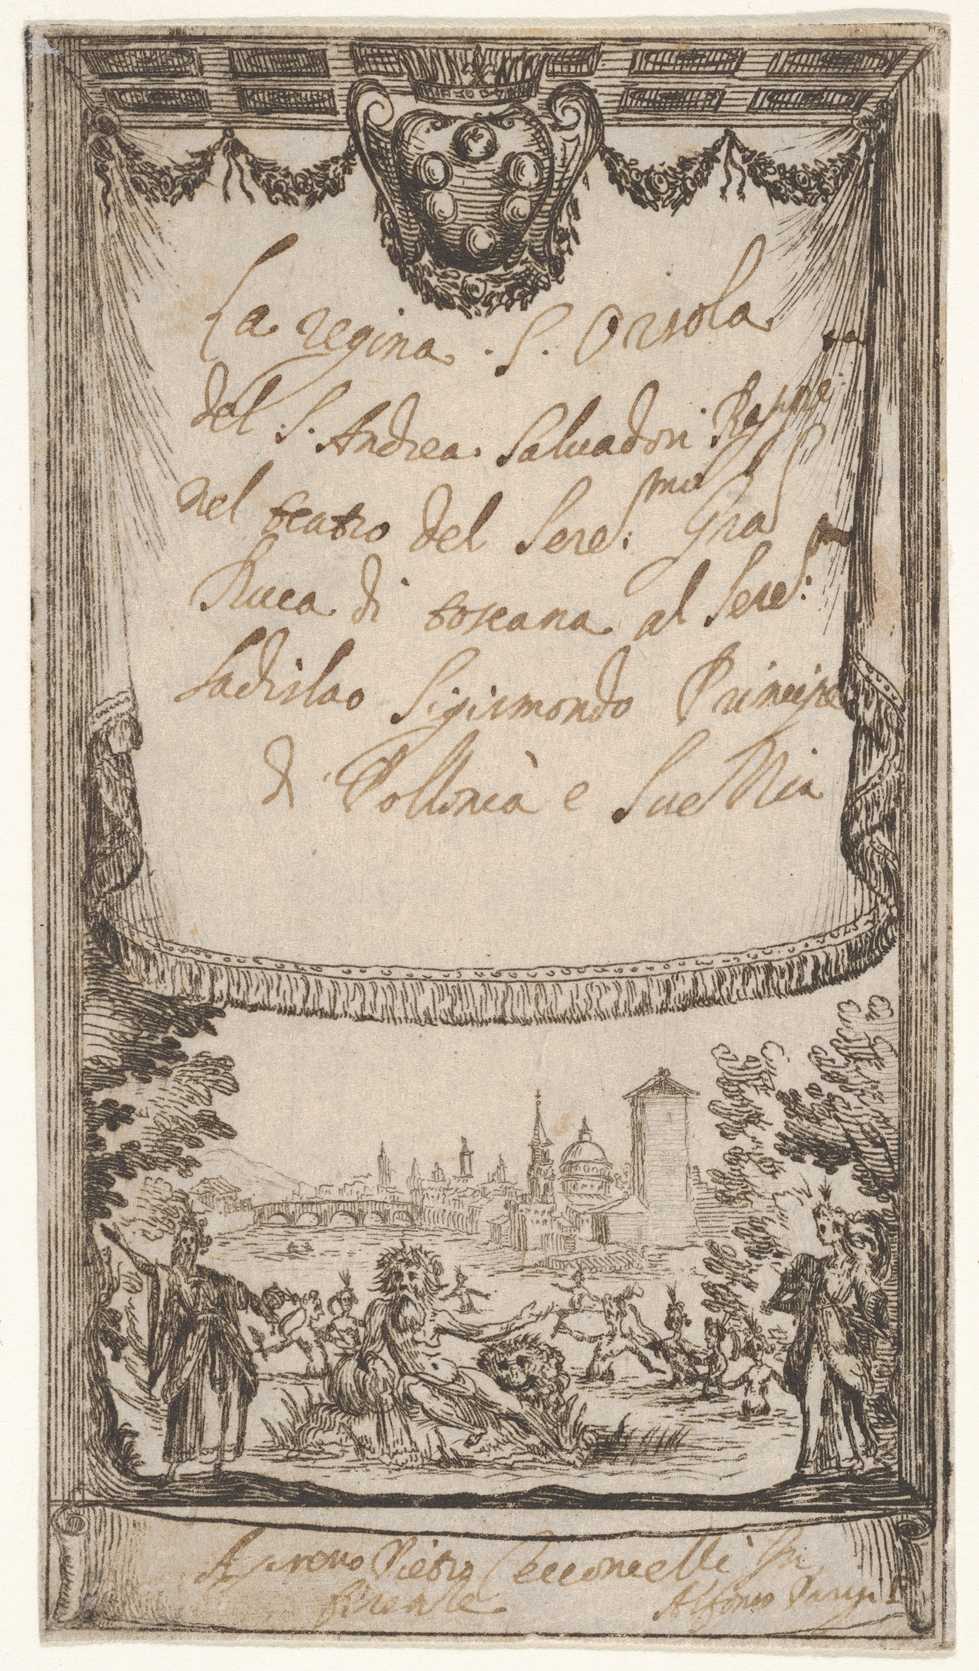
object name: print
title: Frontispiece: Queenly St. Ursula (La Regina Sant'Orsola), from a series of prints for the performance of the St. Ursula tragedy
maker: alfonso parigi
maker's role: artist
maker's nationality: italian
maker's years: 1625-1656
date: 1640-1656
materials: ink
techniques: etching, pen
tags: human figures,animals